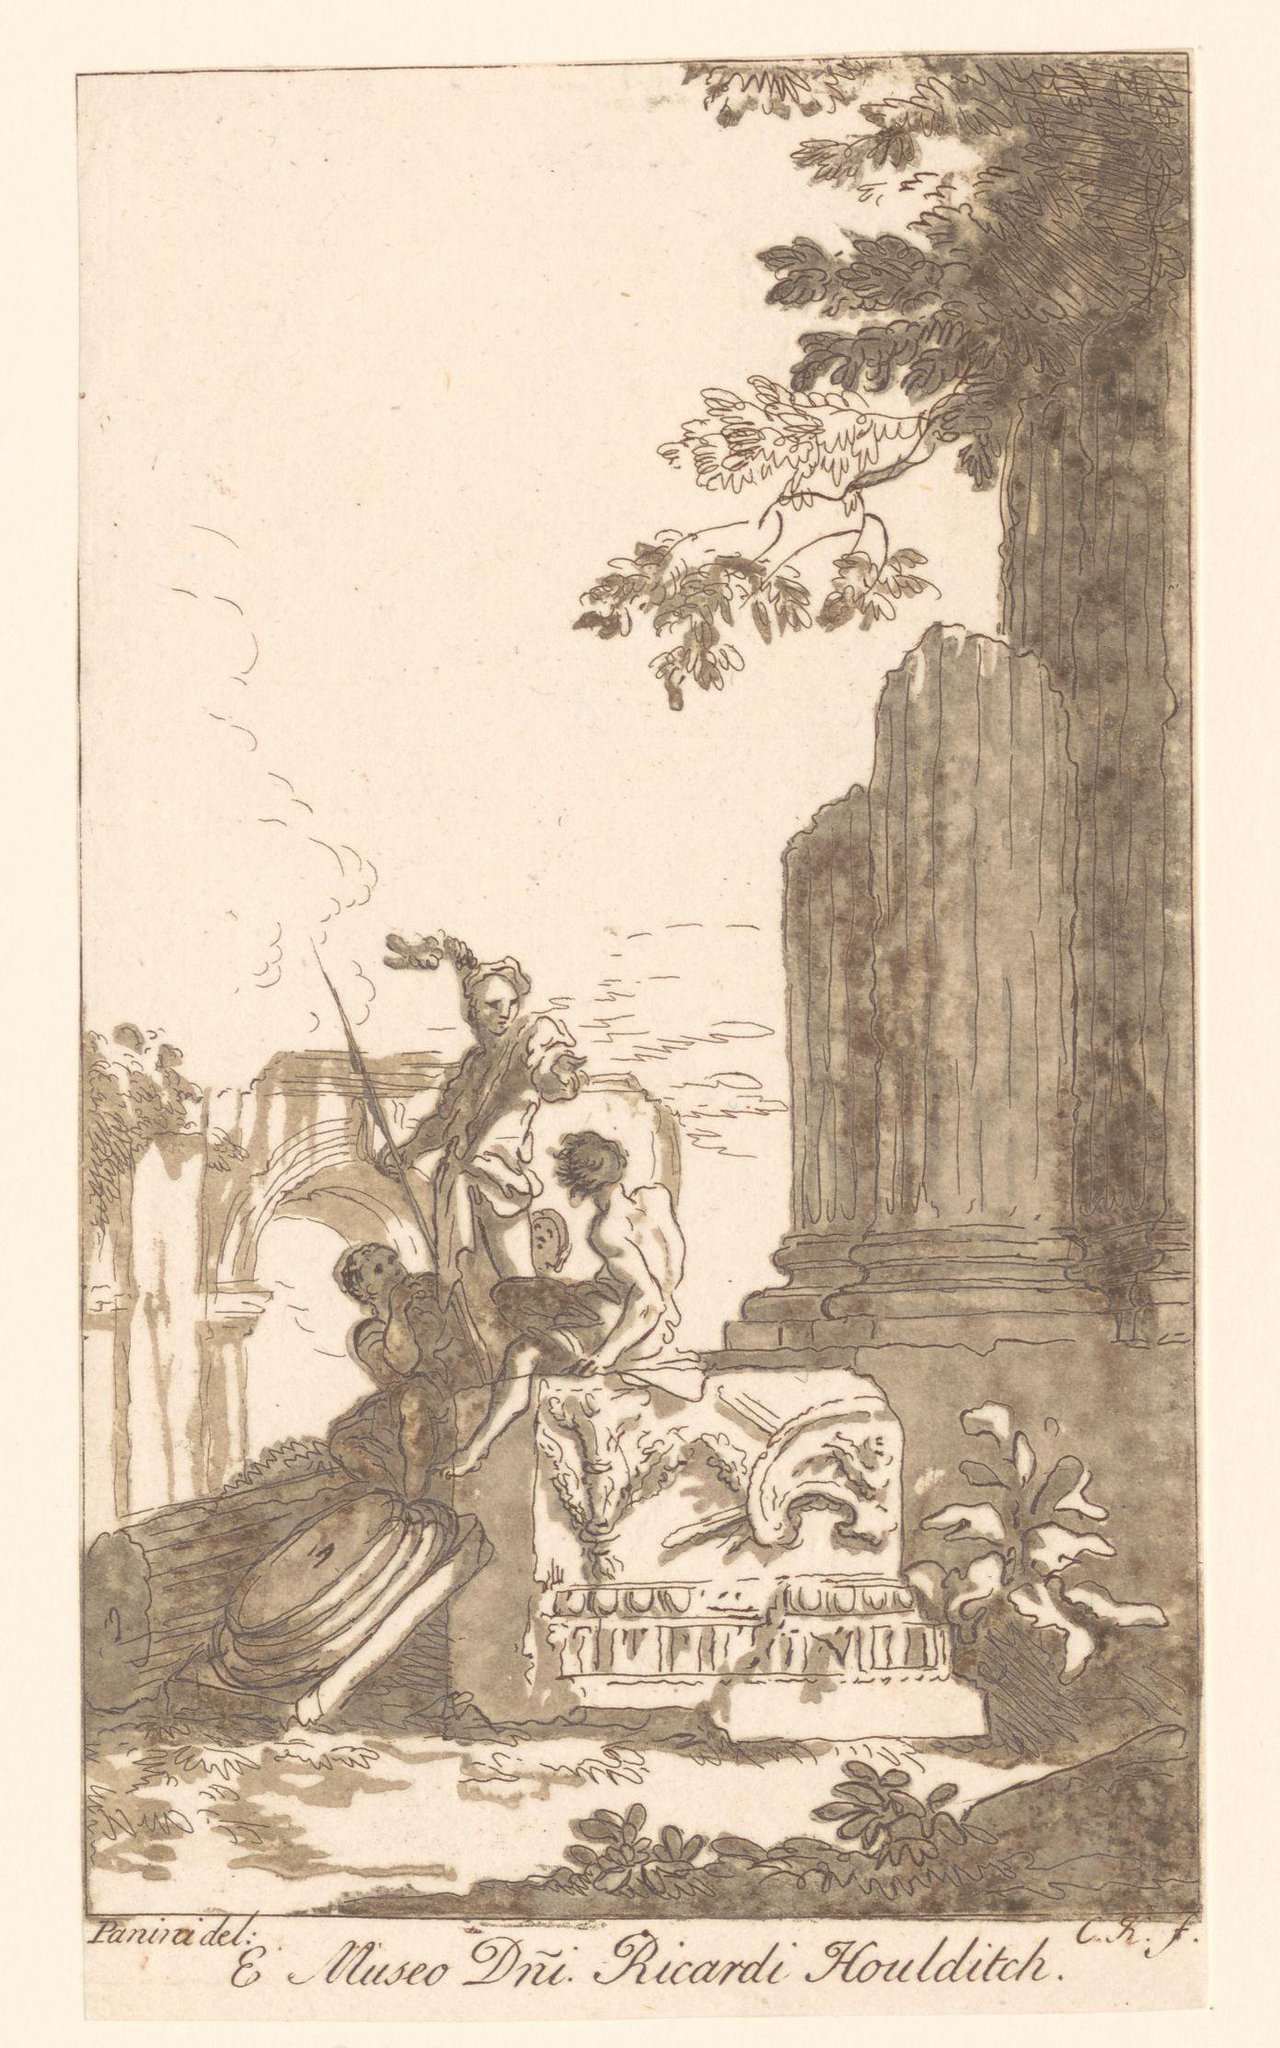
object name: print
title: Figuren bij ruïnes en sculpturen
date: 1732-1736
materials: paper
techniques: etching, hand coloring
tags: sculpture, landscape with ruins - ii - ideal landscapes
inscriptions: collector's mark: Lugt 2228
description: Tekst in het Italiaans in de ondermarge.